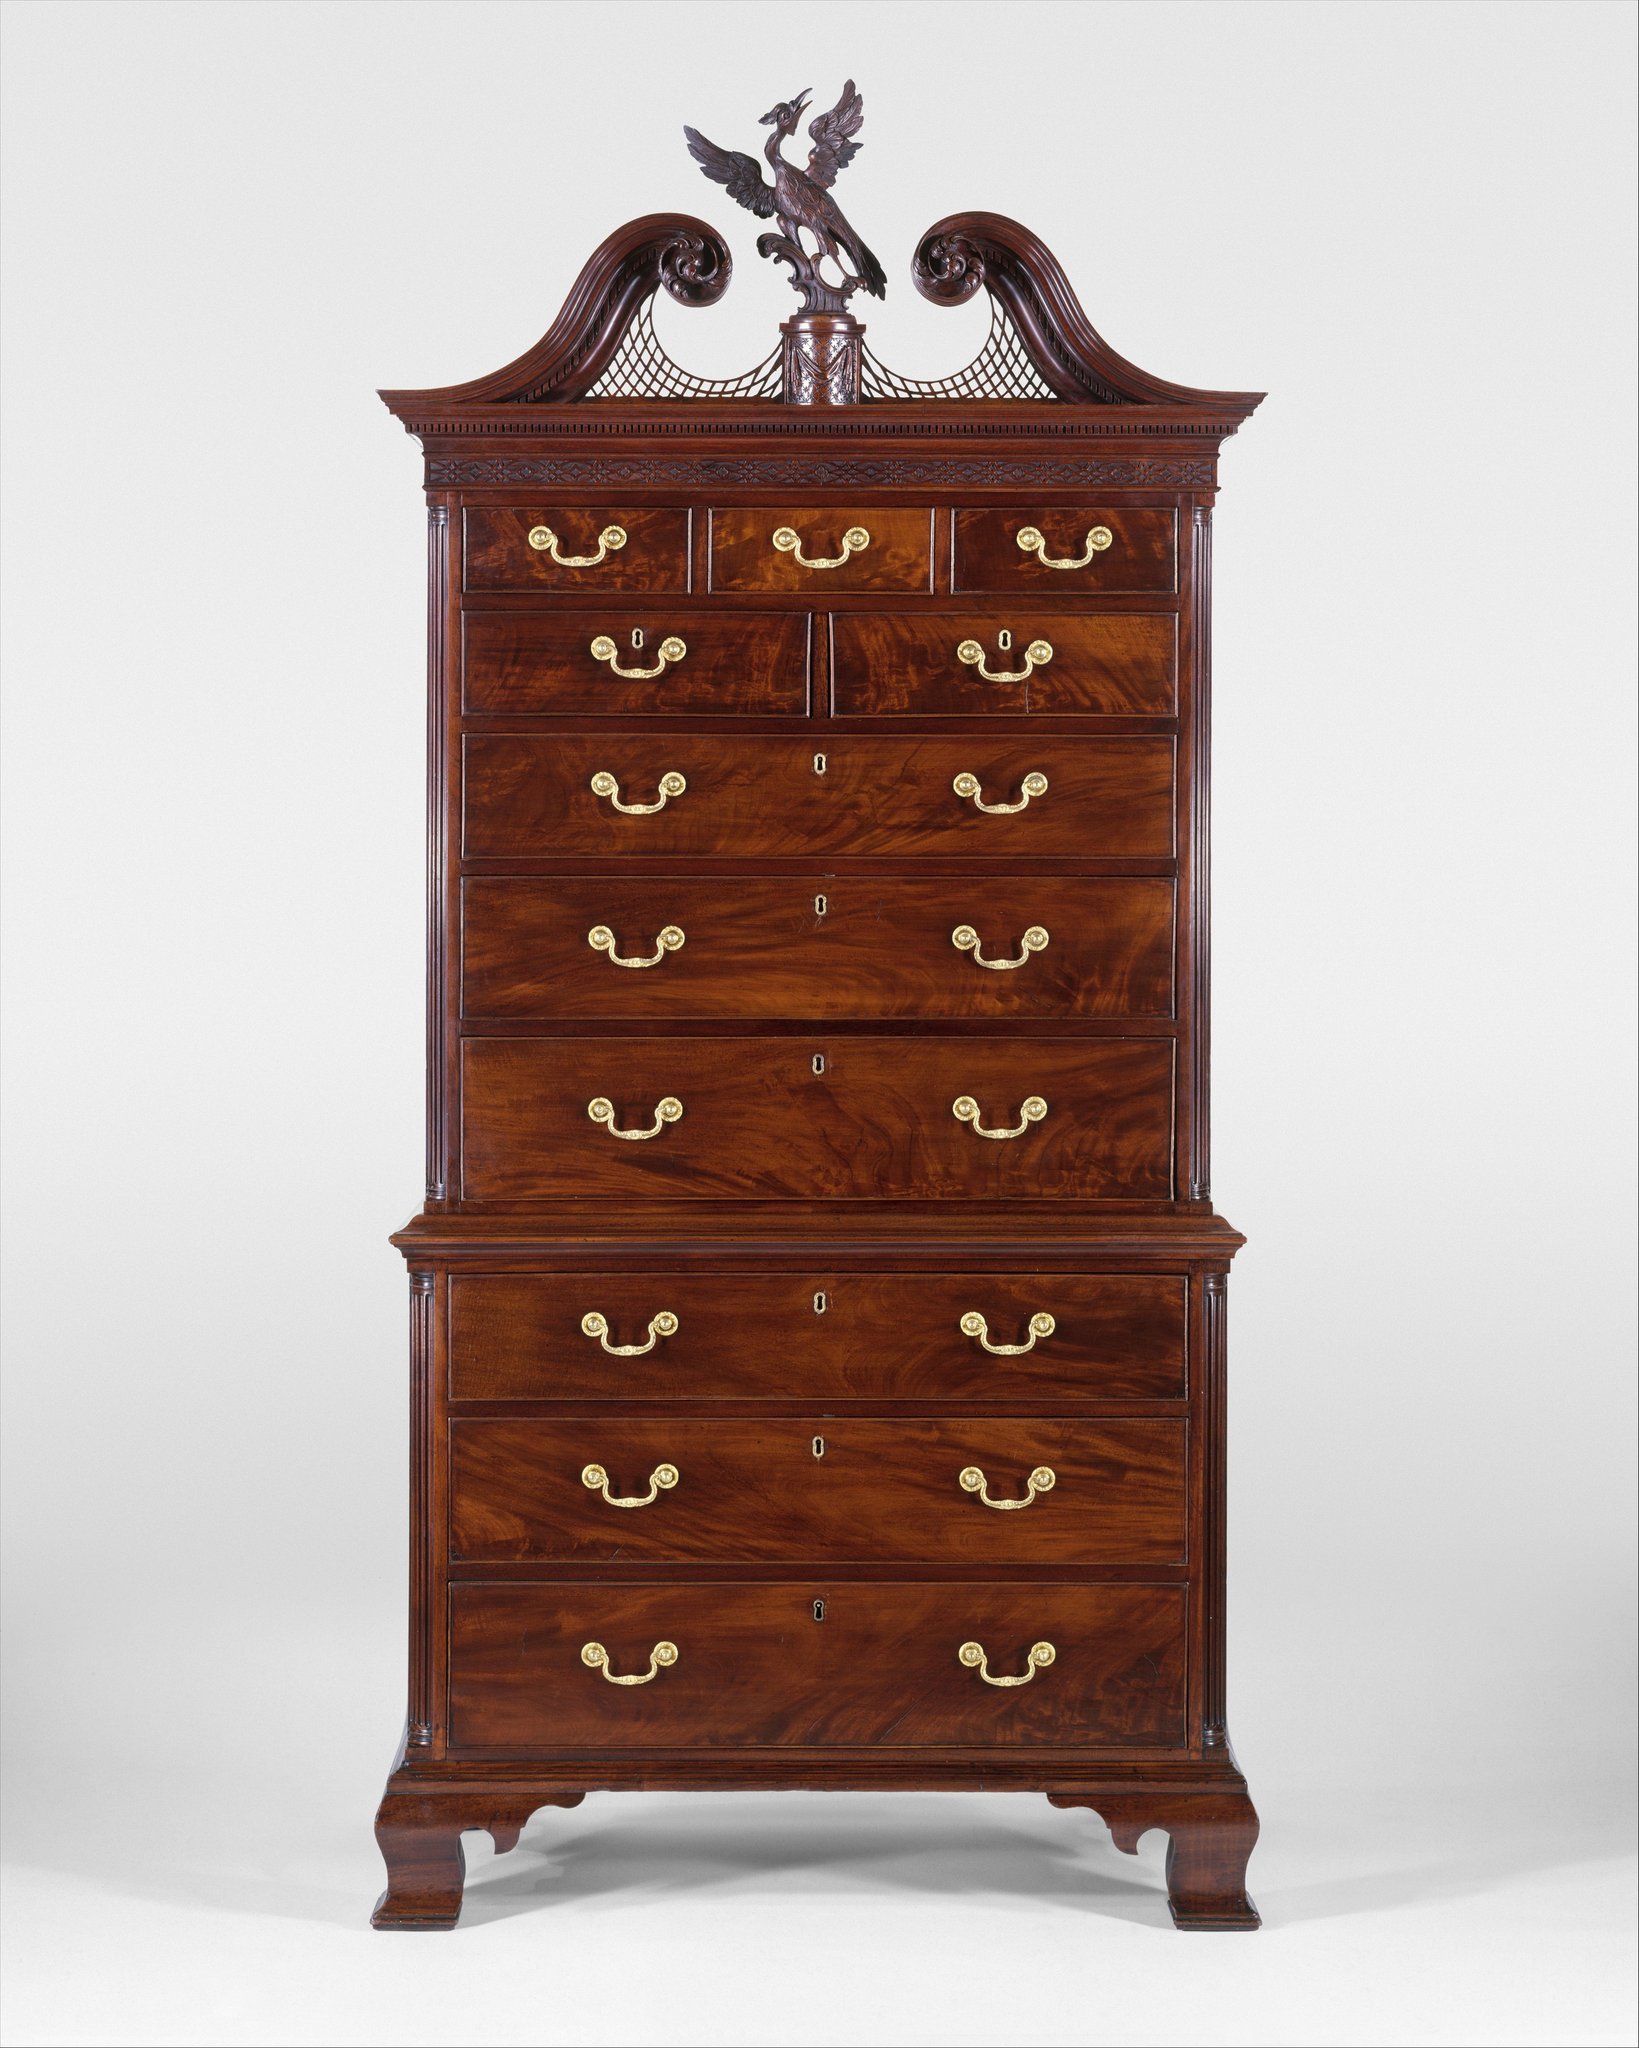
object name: chest on chest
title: Chest-on-chest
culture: american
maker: thomas affleck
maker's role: maker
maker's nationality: american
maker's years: 1740-1795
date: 1770-1775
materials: wood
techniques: veneering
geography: united states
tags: birds